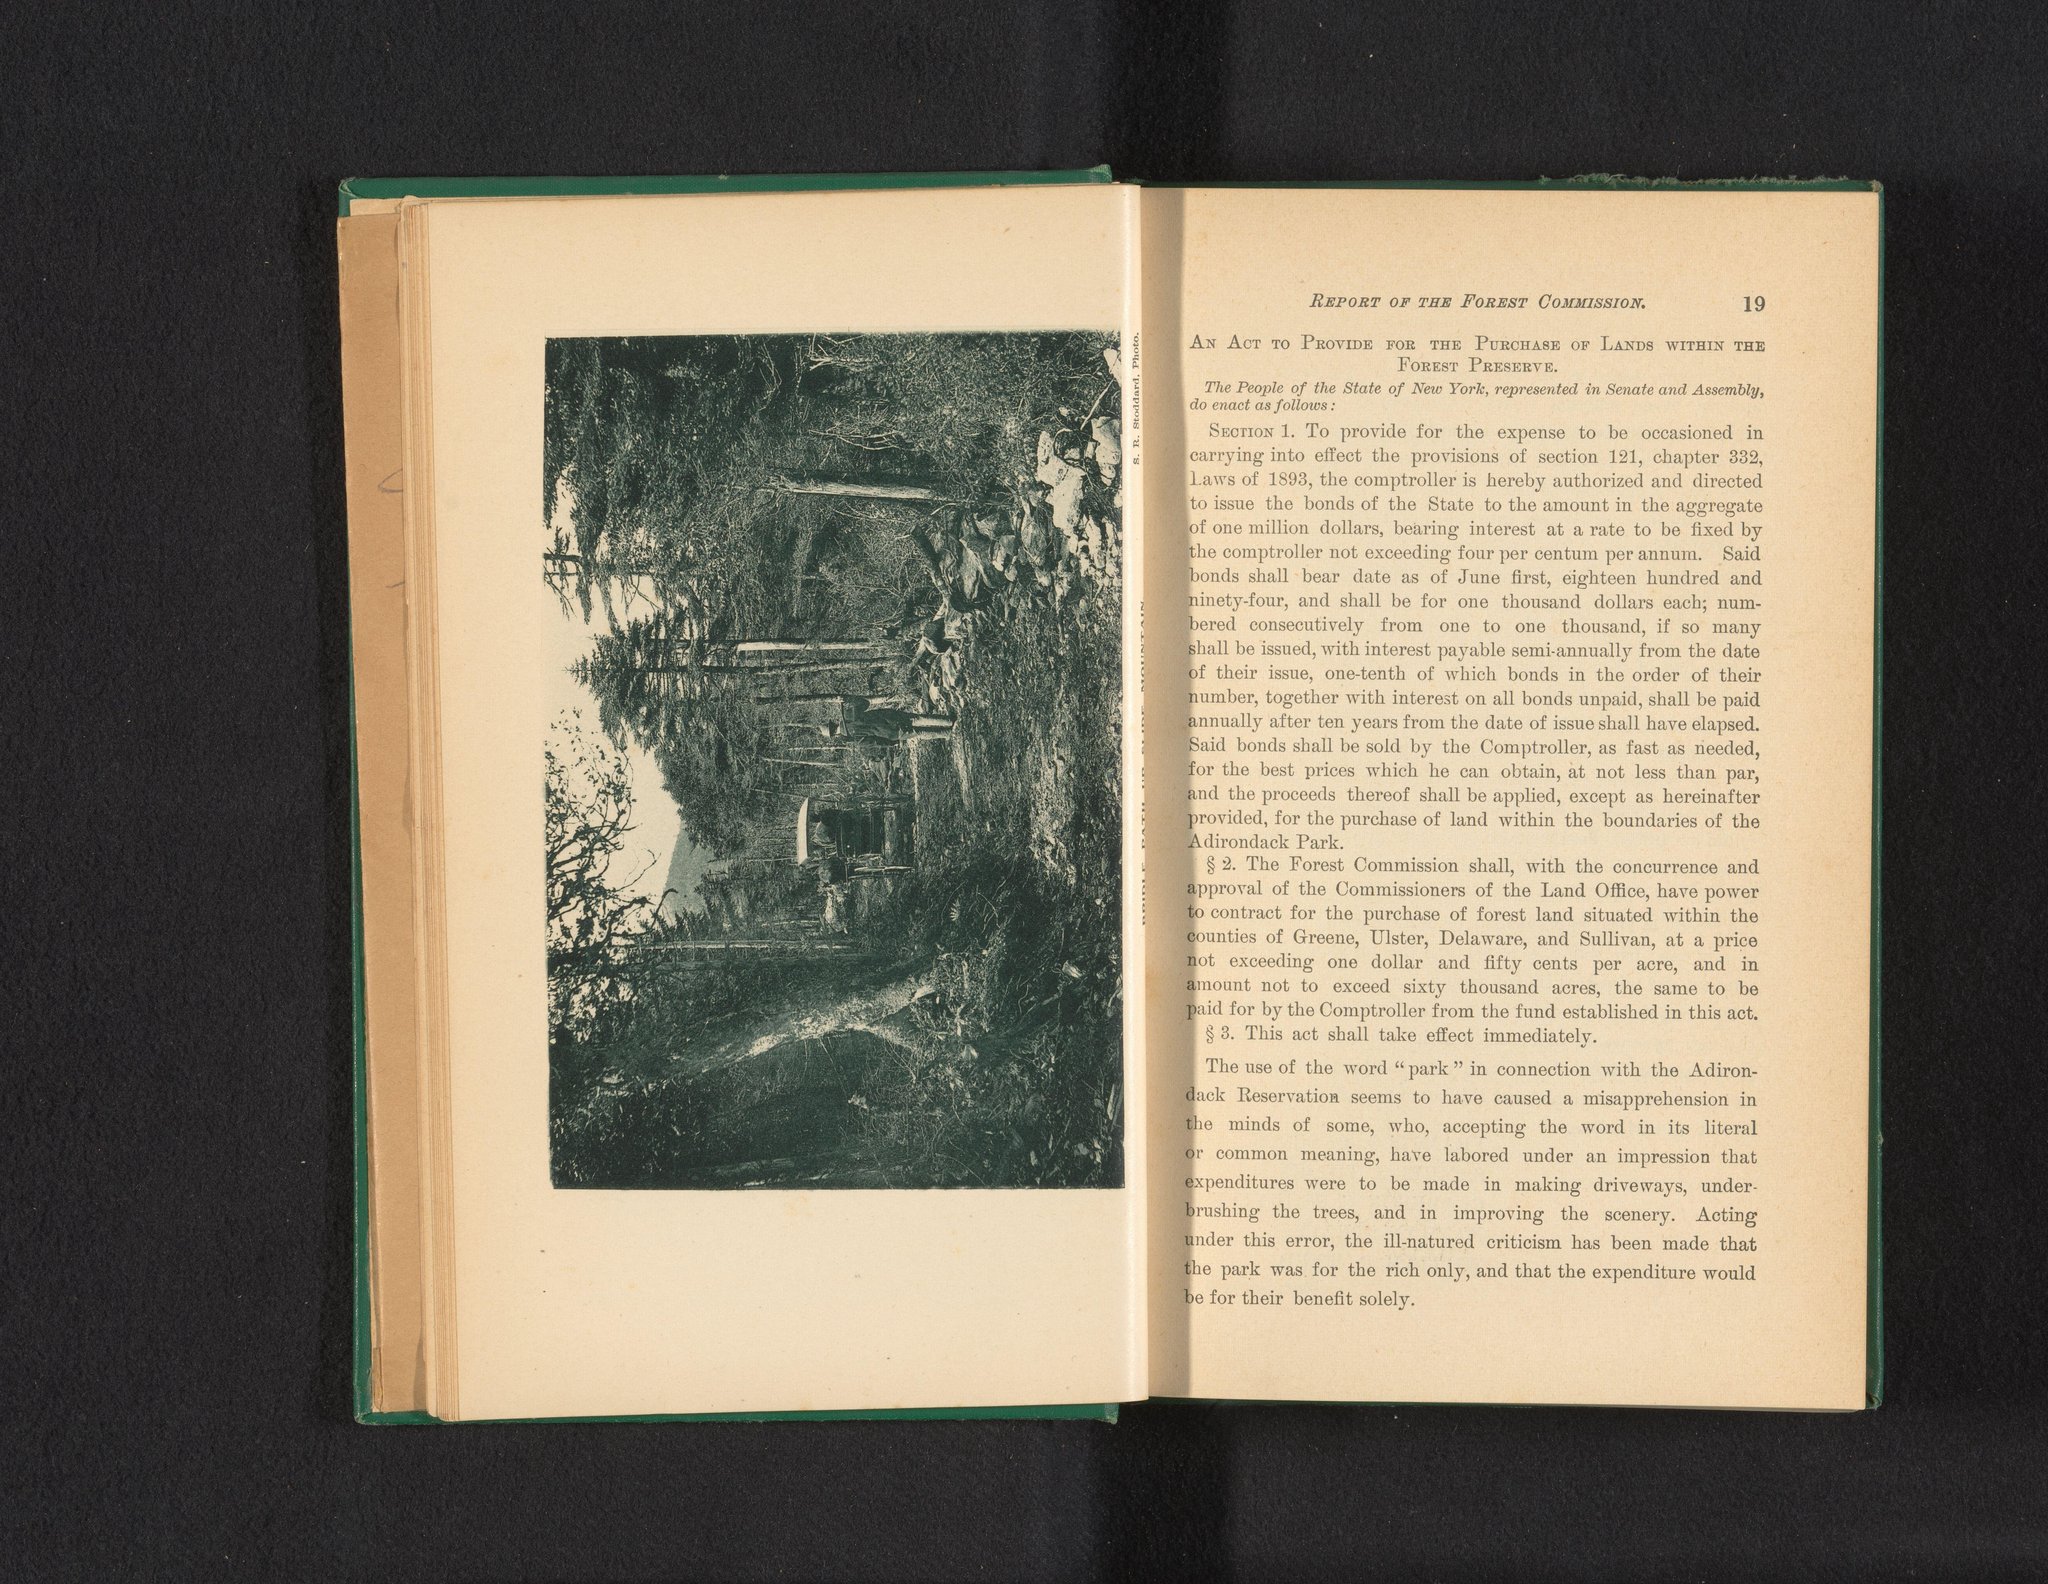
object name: page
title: Bridle path up Slide Mountain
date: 1893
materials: paper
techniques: photograph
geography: catskill mountains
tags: public road, mountains